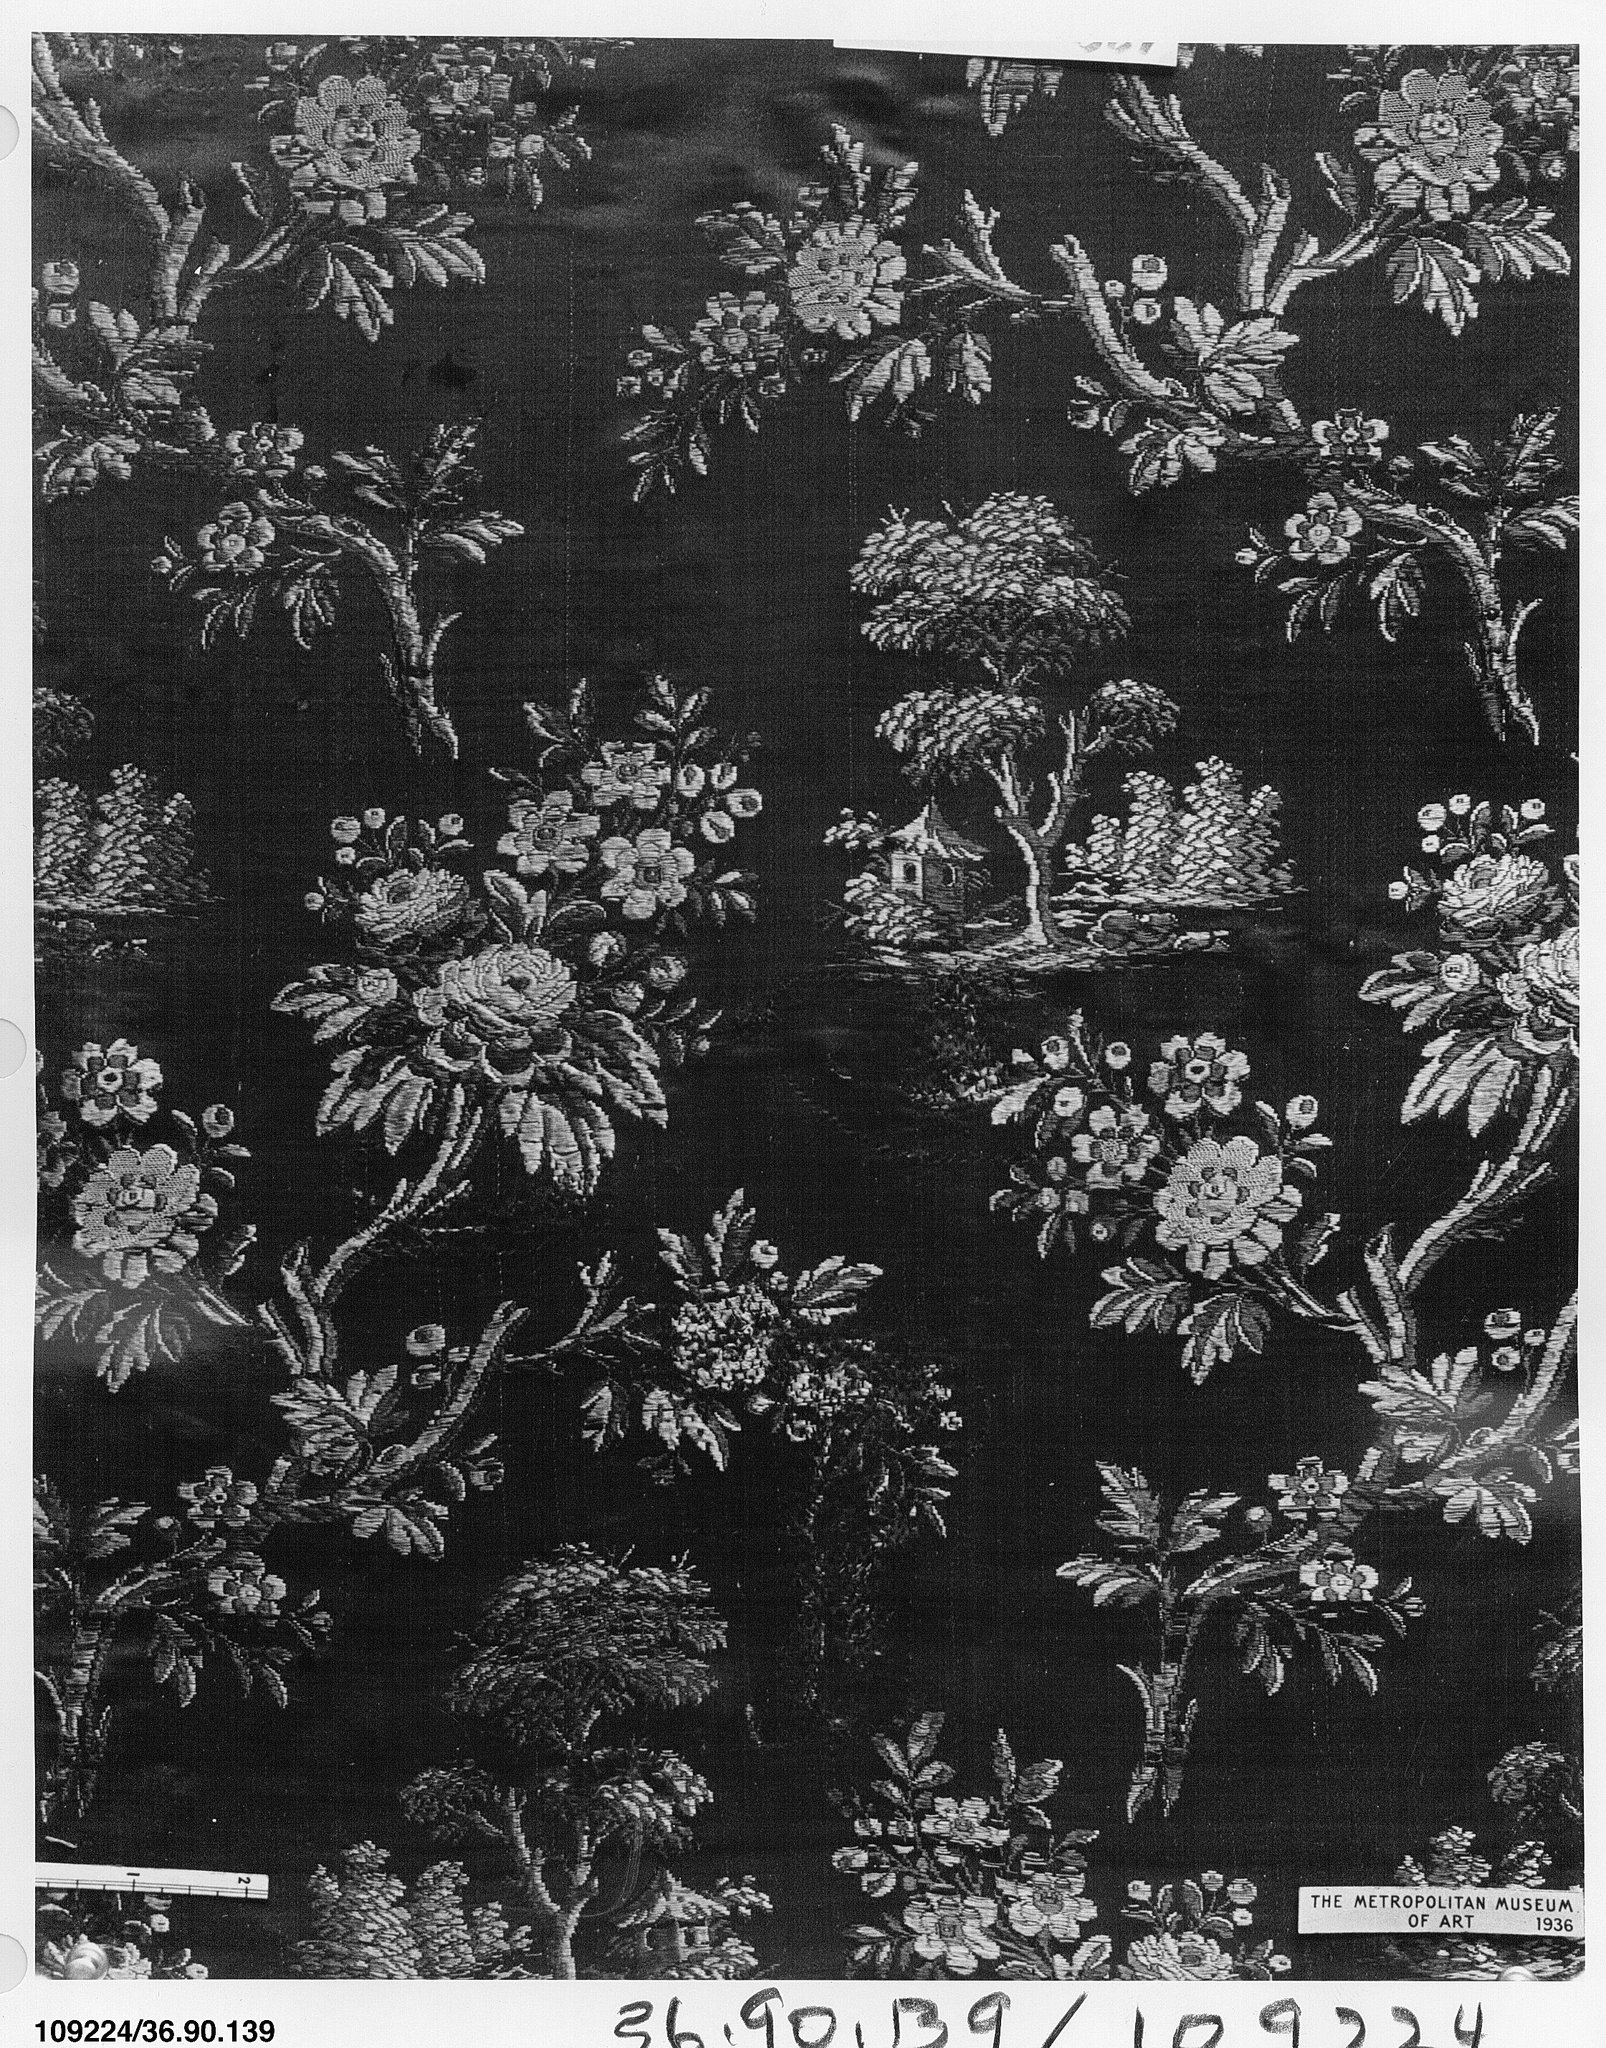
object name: piece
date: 1750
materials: silk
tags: flowers,leaves,trees